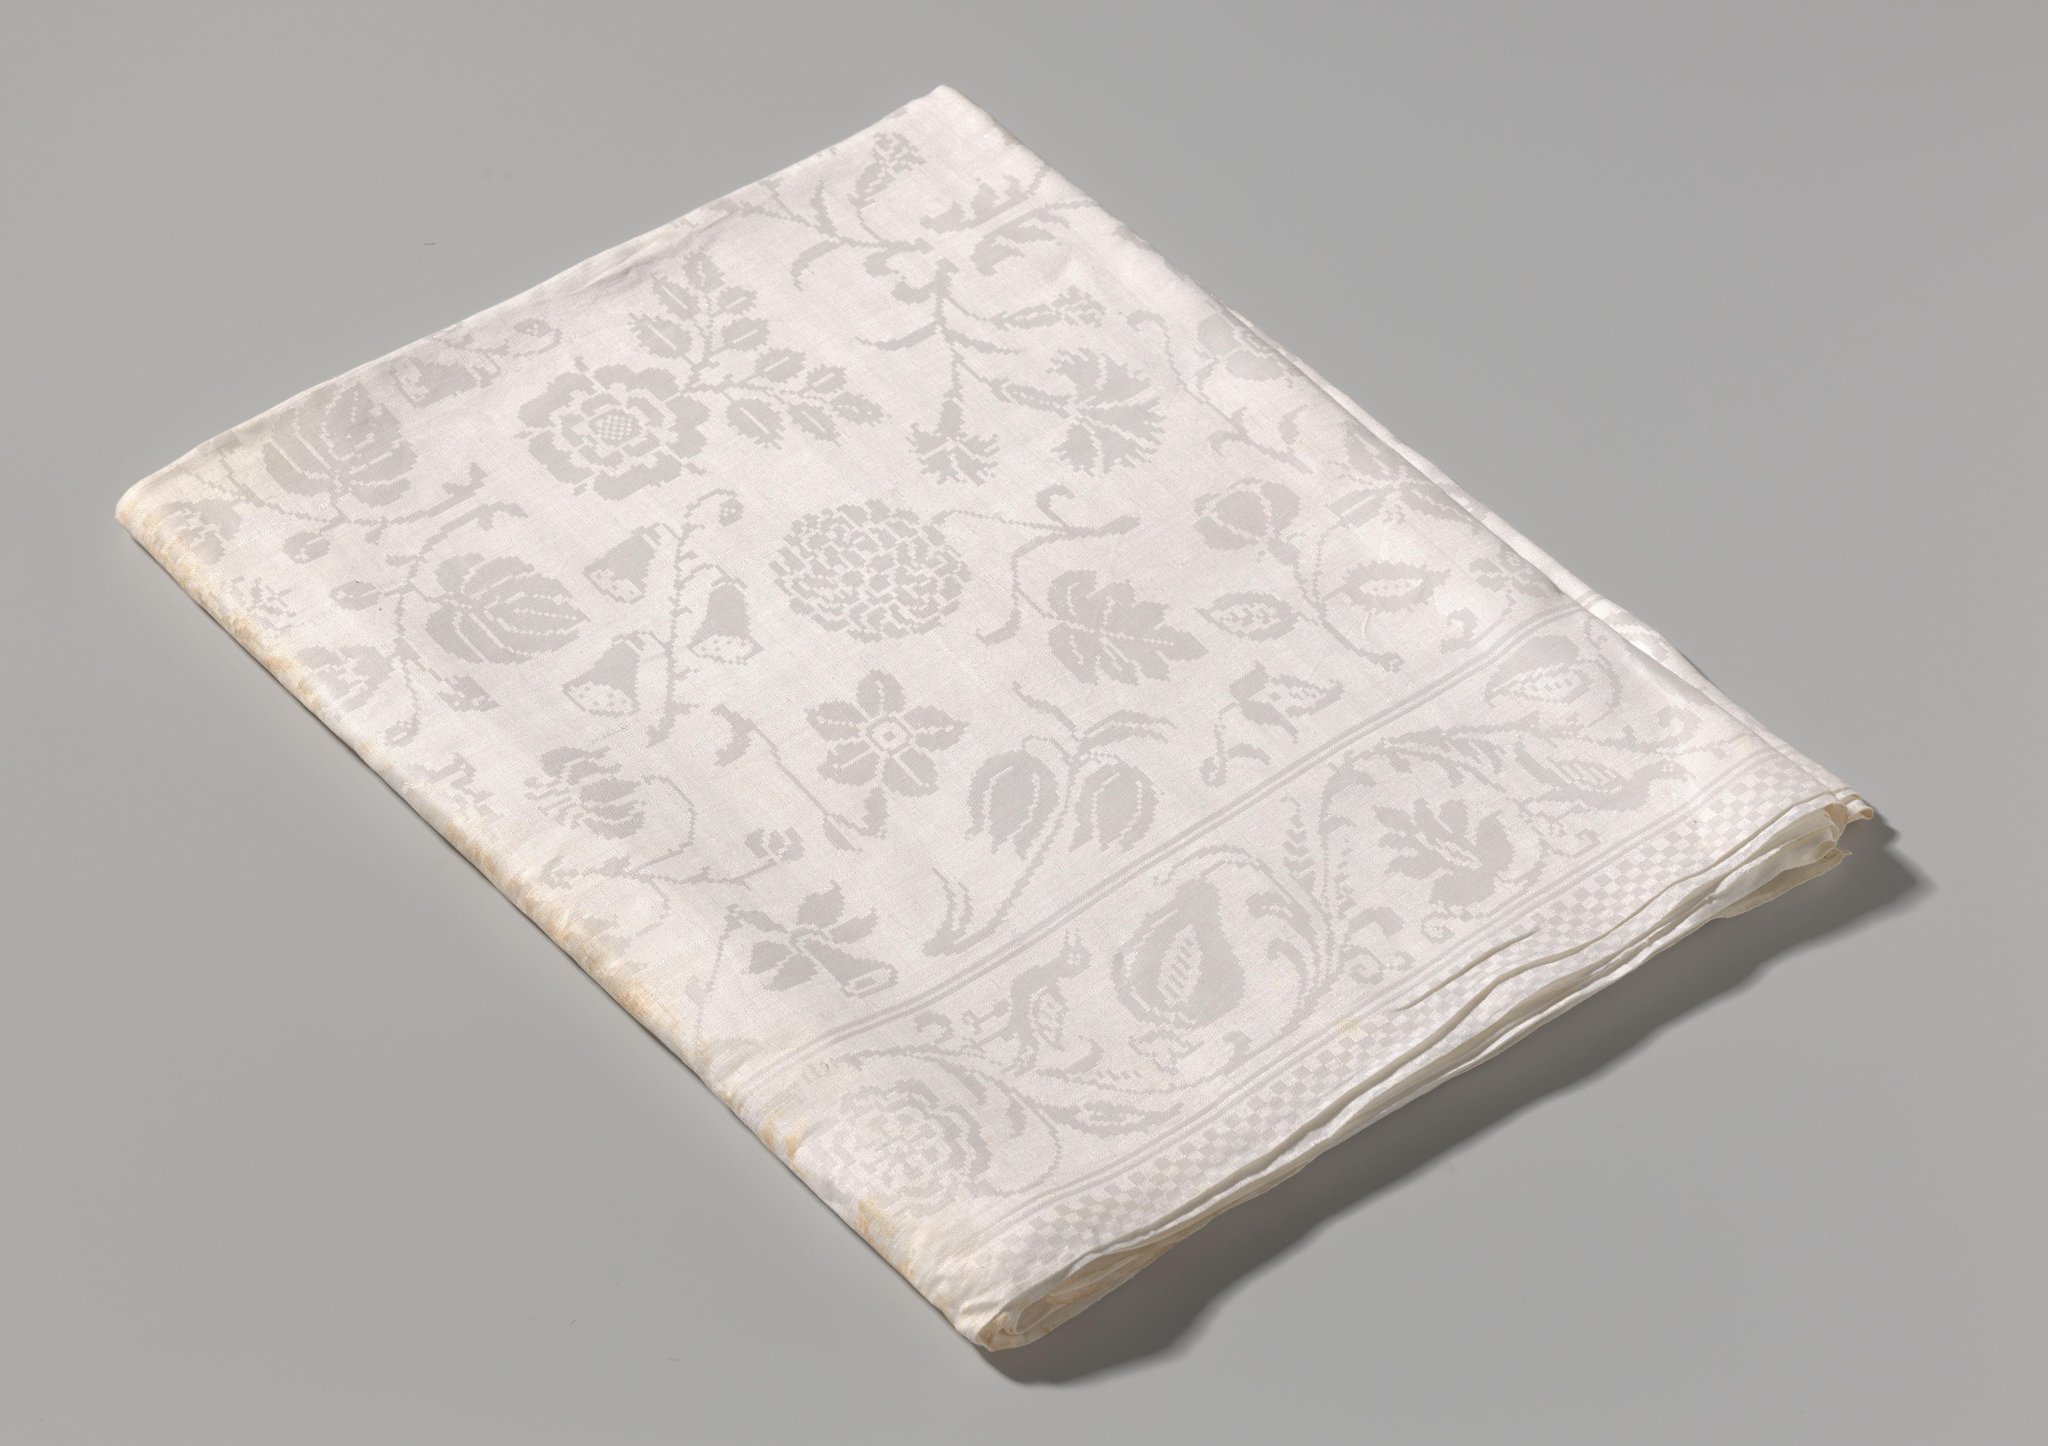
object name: tablecloth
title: Gestrooide bloem en de wapens en namen ZOETE VAN LAEKE en HARTAING.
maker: Anonymous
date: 1603-1634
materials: linen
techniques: damask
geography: netherlands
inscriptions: mark: ‘GL 2’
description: Tafellaken van wit linnendamast met gestrooide bloem en de wapens en namen ZOETE VAN LAEKE en HARTAING.